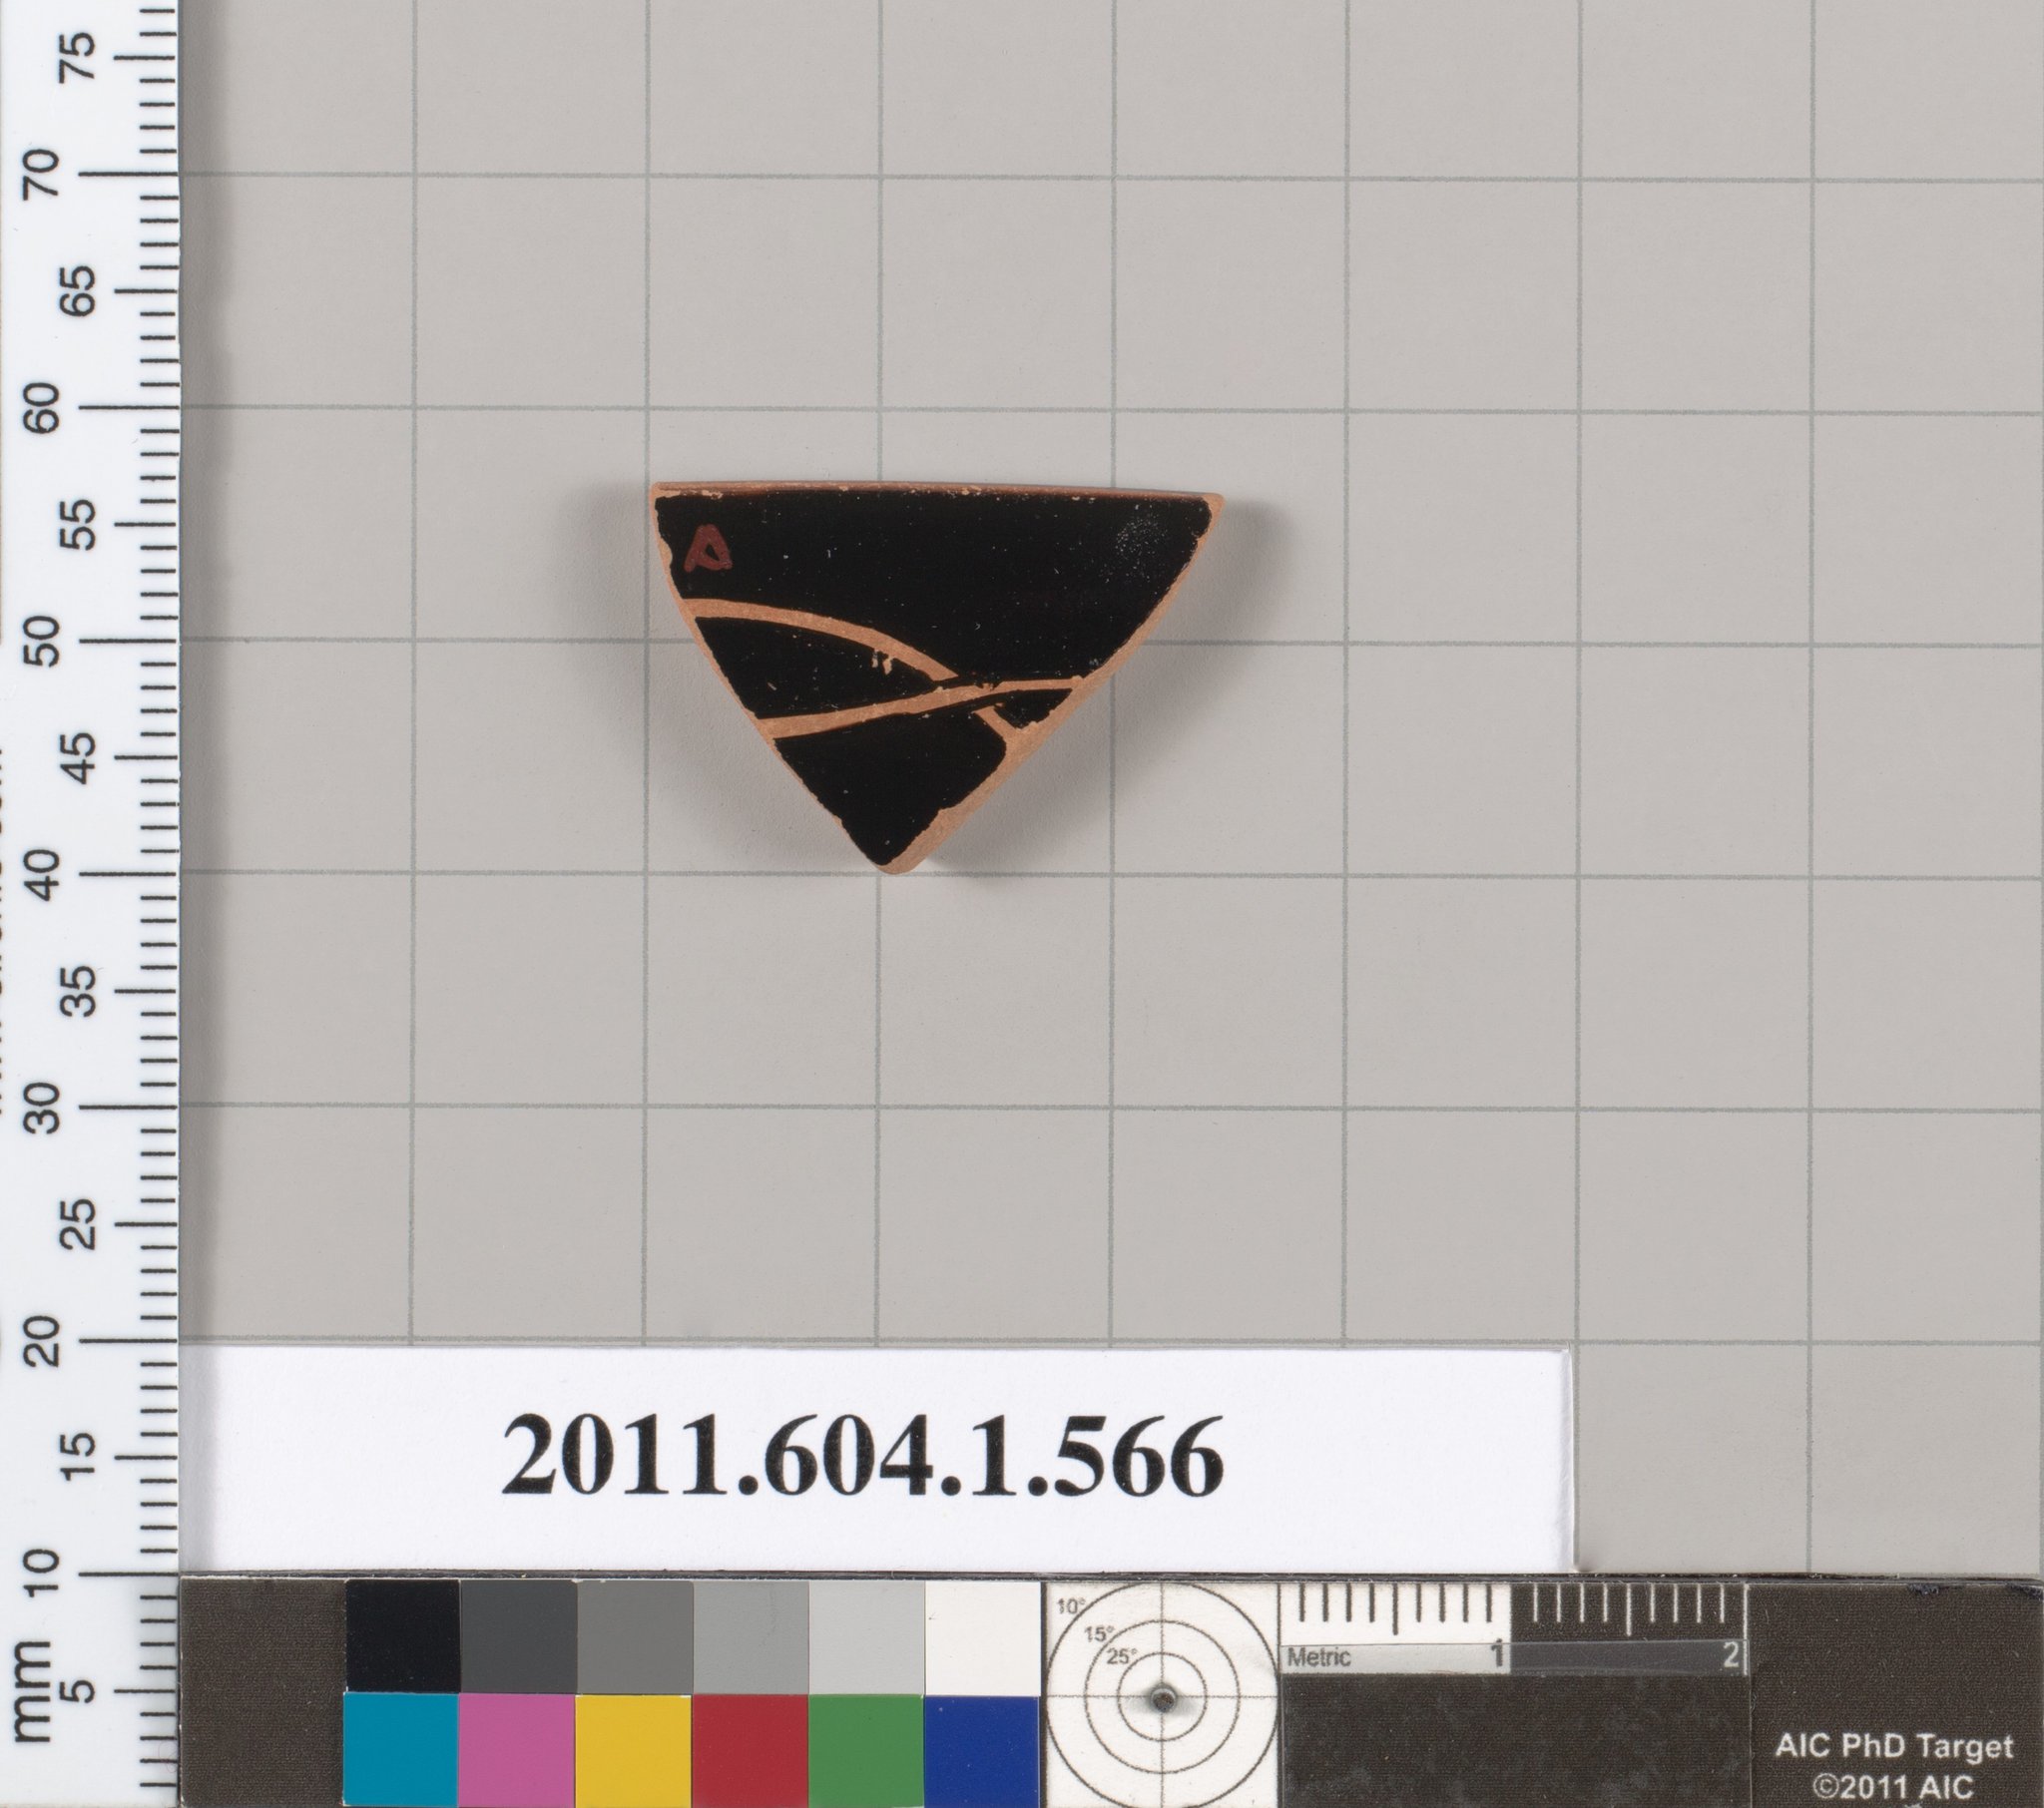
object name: kylix fragment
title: Terracotta rim fragment of a kylix (drinking cup)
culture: greek, attic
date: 480-470 BCE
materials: terracotta